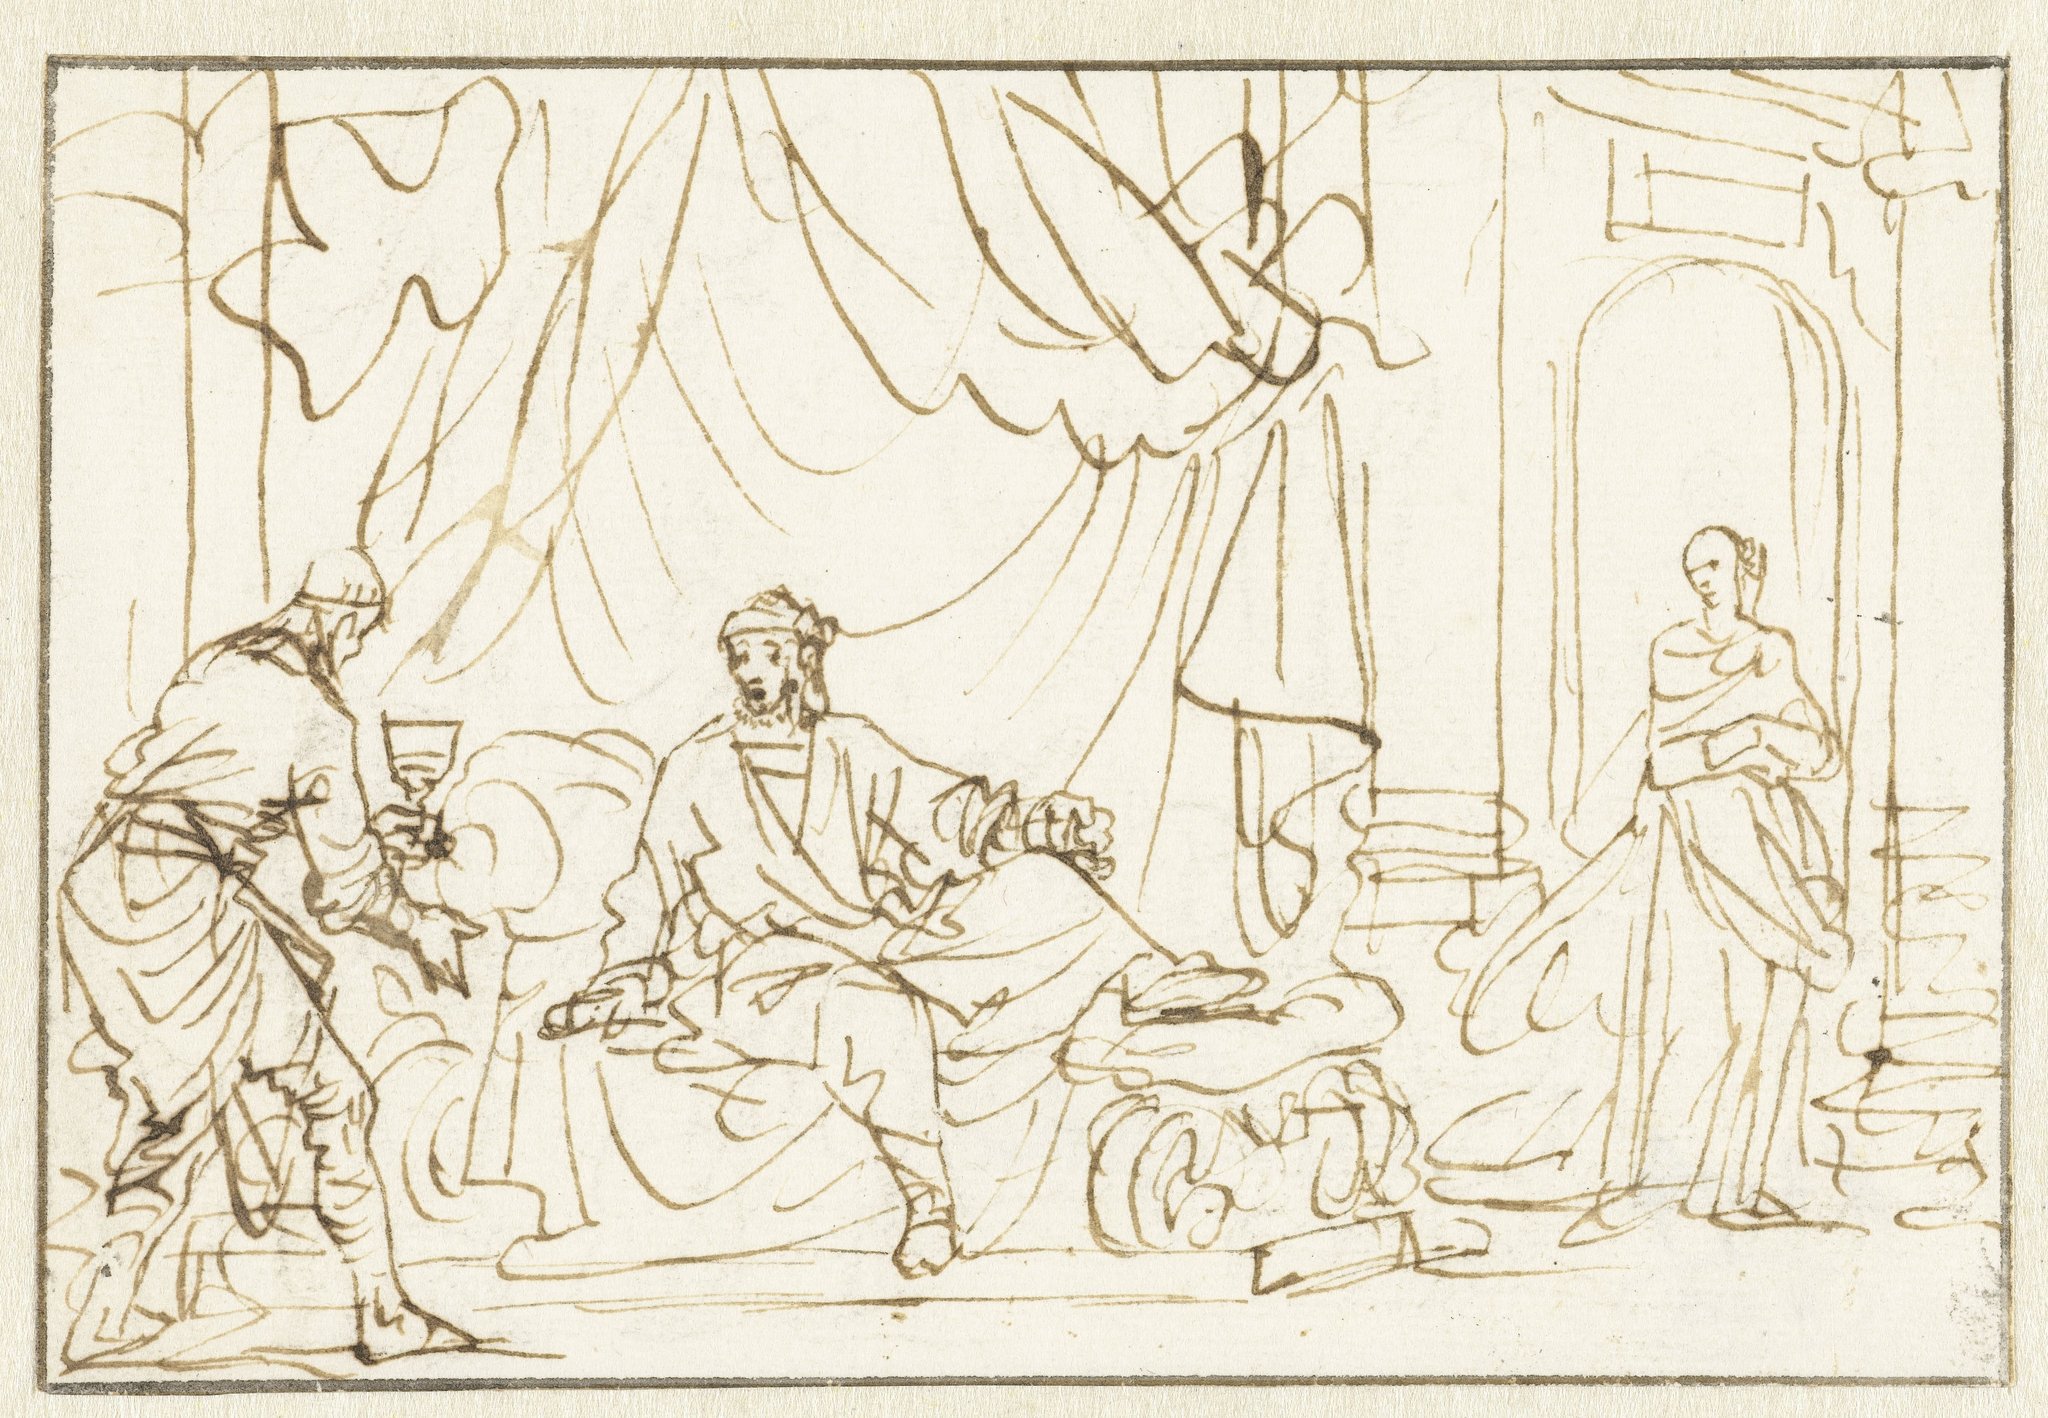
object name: design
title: Herodes vermoedt dat zijn echtgenote Mariamne hem wil vergiftigen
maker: jan luyken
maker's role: draughtsman, print maker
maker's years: 1649-1712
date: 1702-1704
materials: ink, paper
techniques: pen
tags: female persons from classical history (with name), male persons from classical history (herod), (scenes from) specific works of literature (with author, title), violent death by poison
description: Ontwerp voor een prent in 'Joodsche Oudheden' van Josephus.